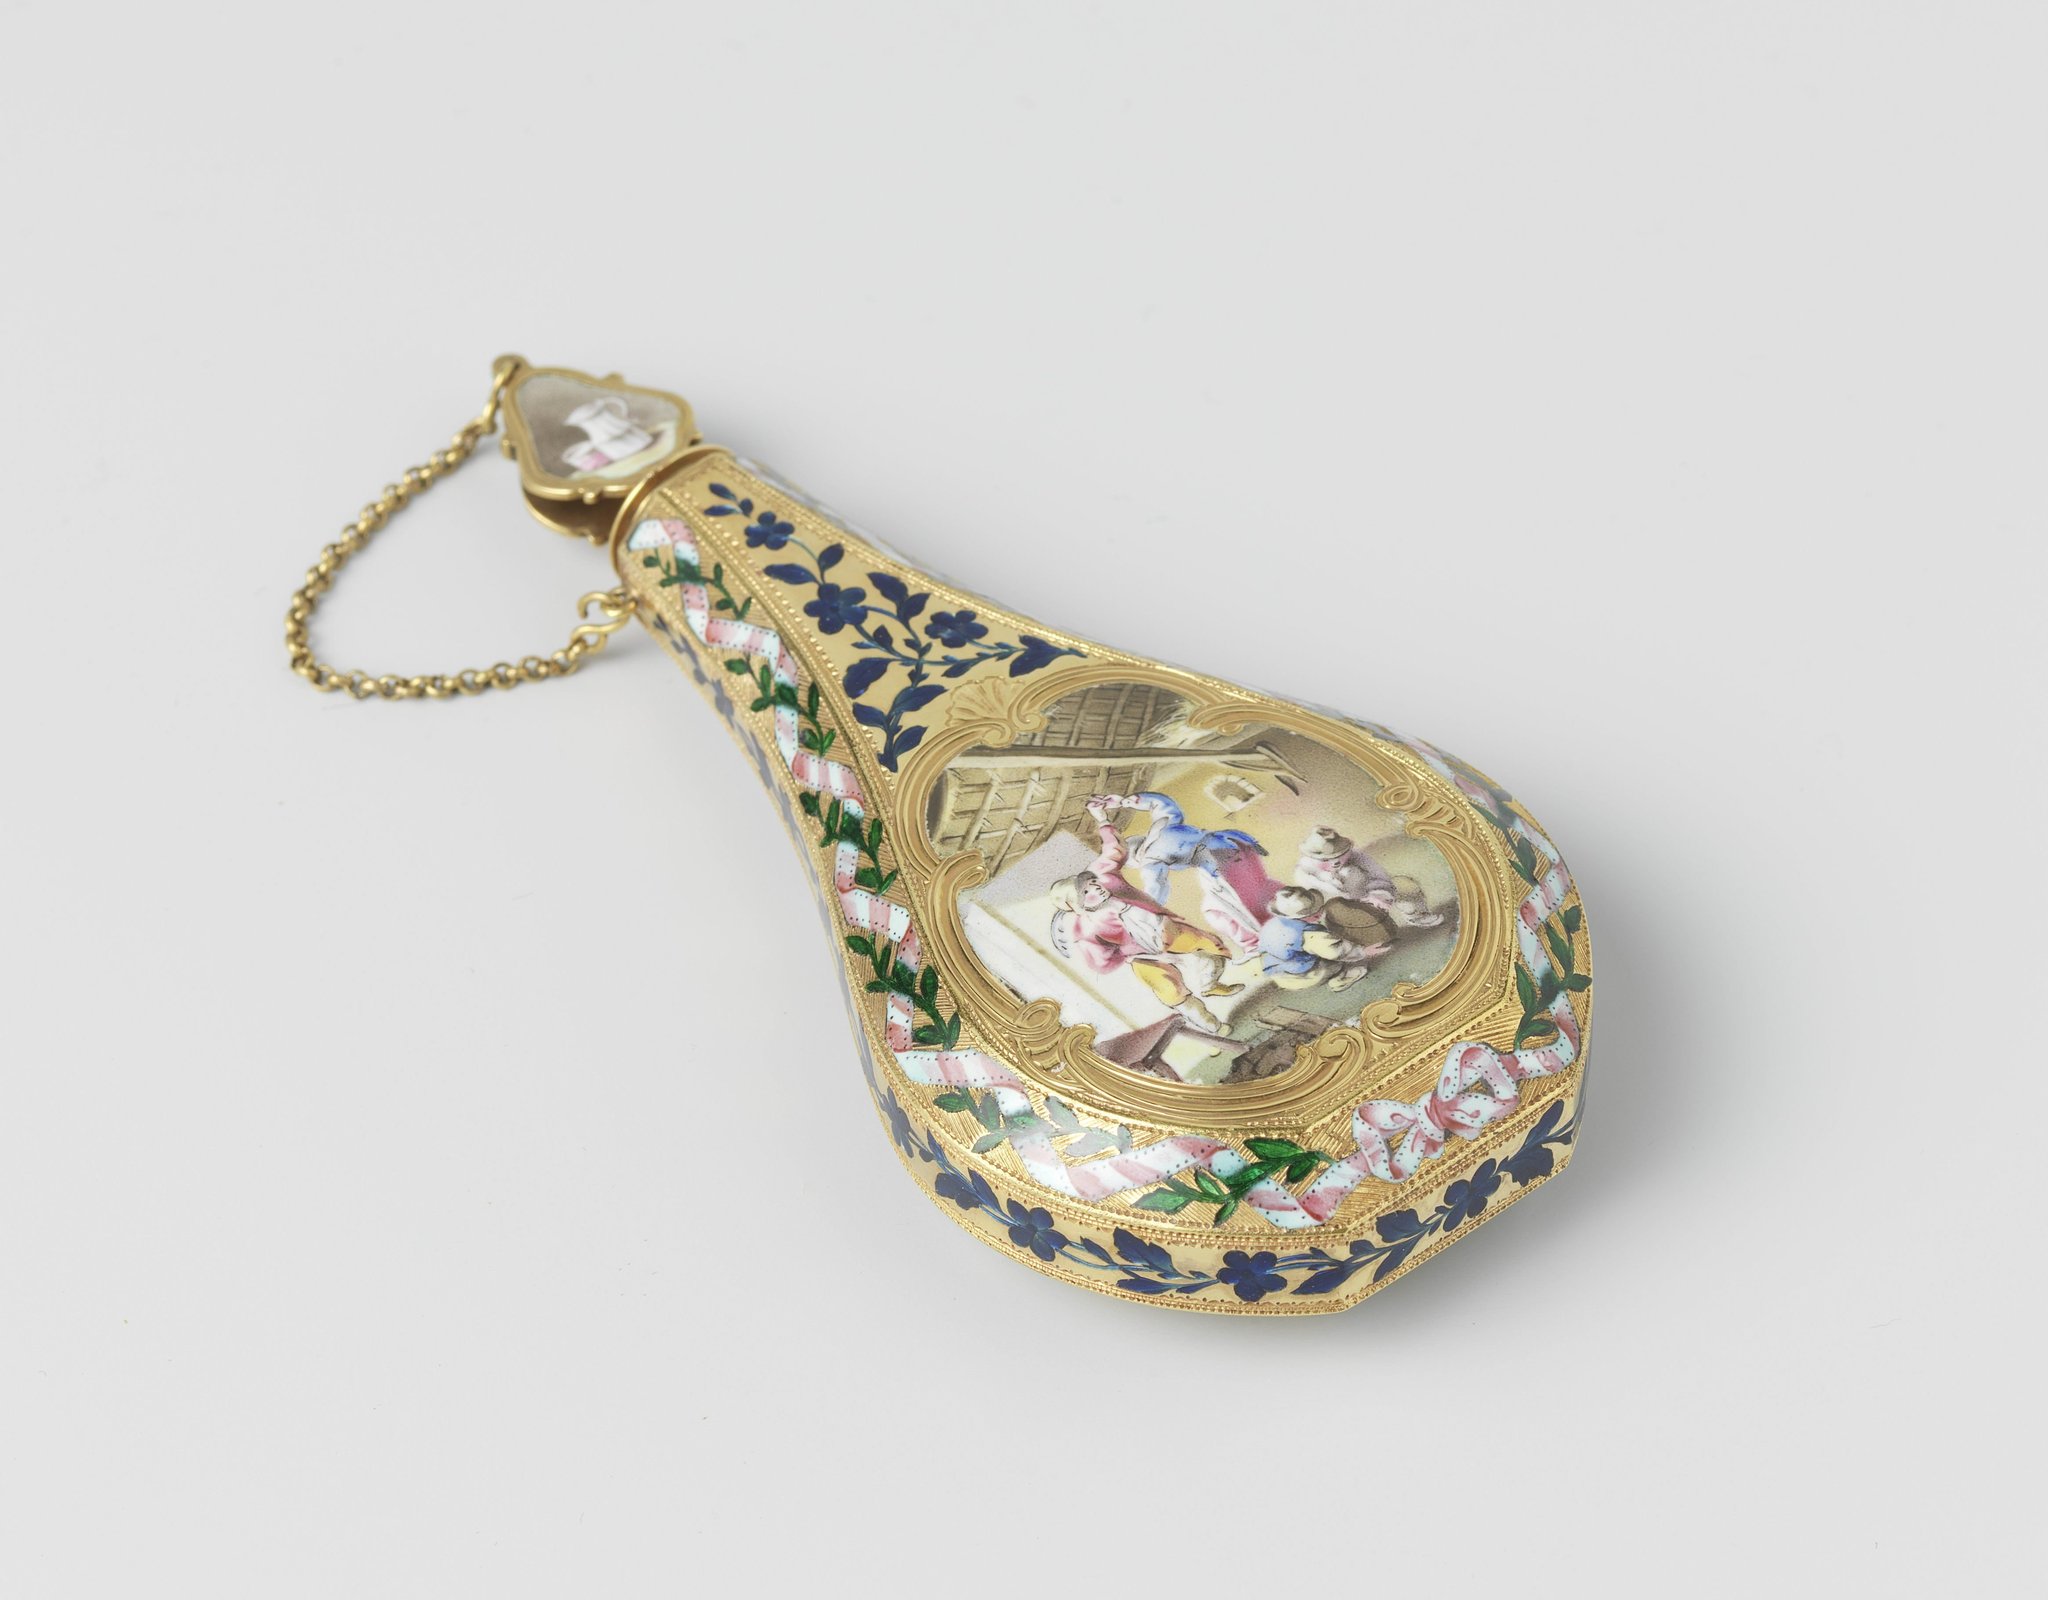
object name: vinaigrette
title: Reukfles van goud, afgeplat peervormig, met op beide zijden taferelen in émail: een boerenkeuken interieur en een boerendans.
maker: Anonymous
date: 1756-1762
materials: gold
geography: paris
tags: one pair dancing; man and woman dancing as a couple, interior of the house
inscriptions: countermark, duty mark: ‘V’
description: Bottle. Gold, enamel. Paris, c. 1760. Snuffbox. Gold, enamel. Paris, 1772 - 1773, by Charles-Barnabé Sageret.